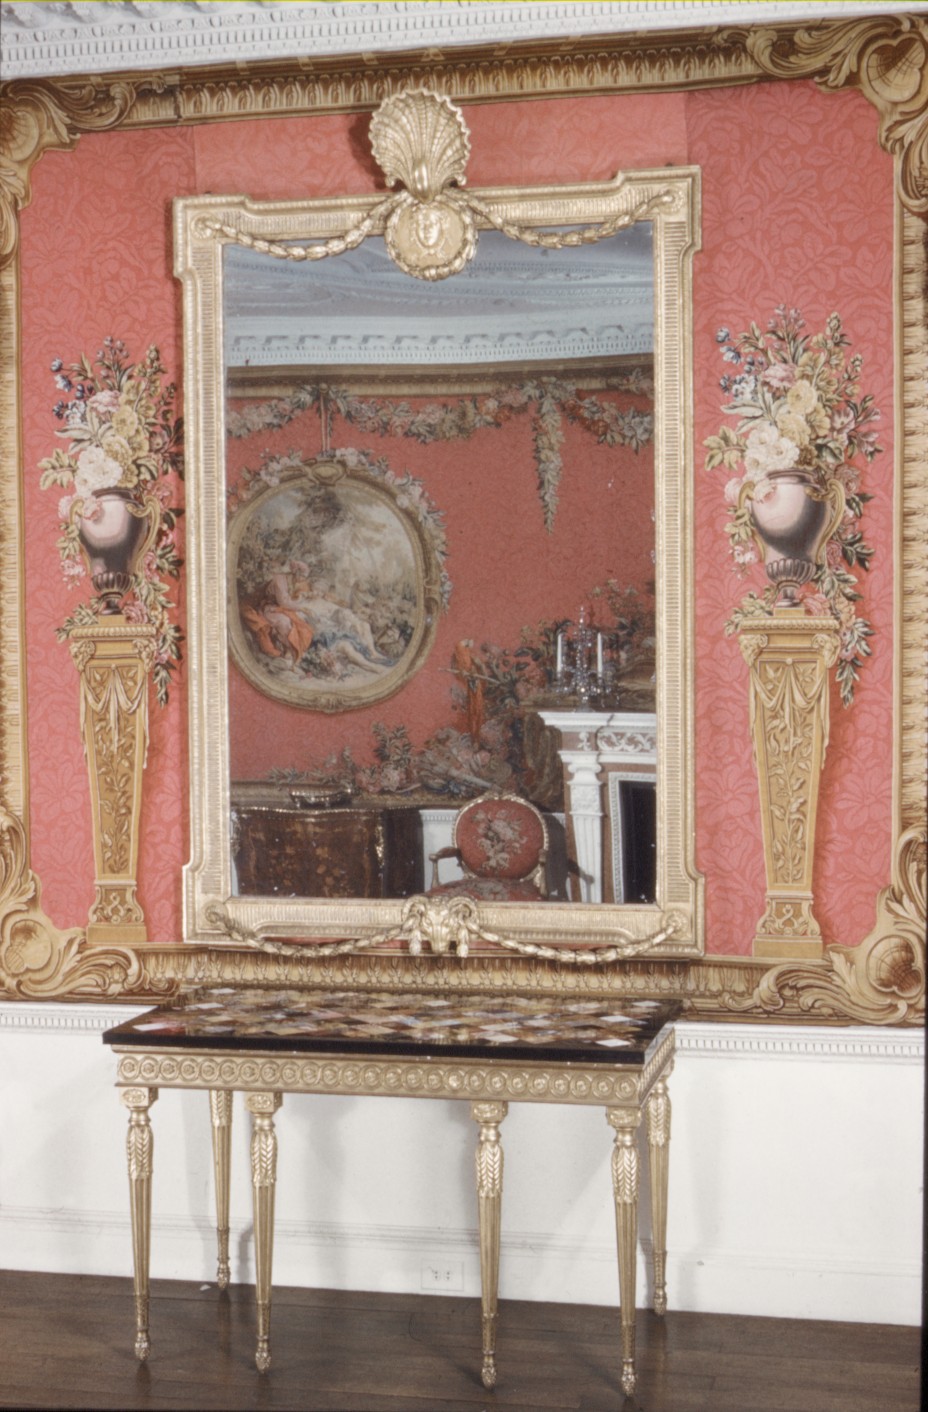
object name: mirror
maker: robert adam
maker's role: designer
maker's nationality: british, scottish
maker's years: 1728-1792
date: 1769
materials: glass, wood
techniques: gilding